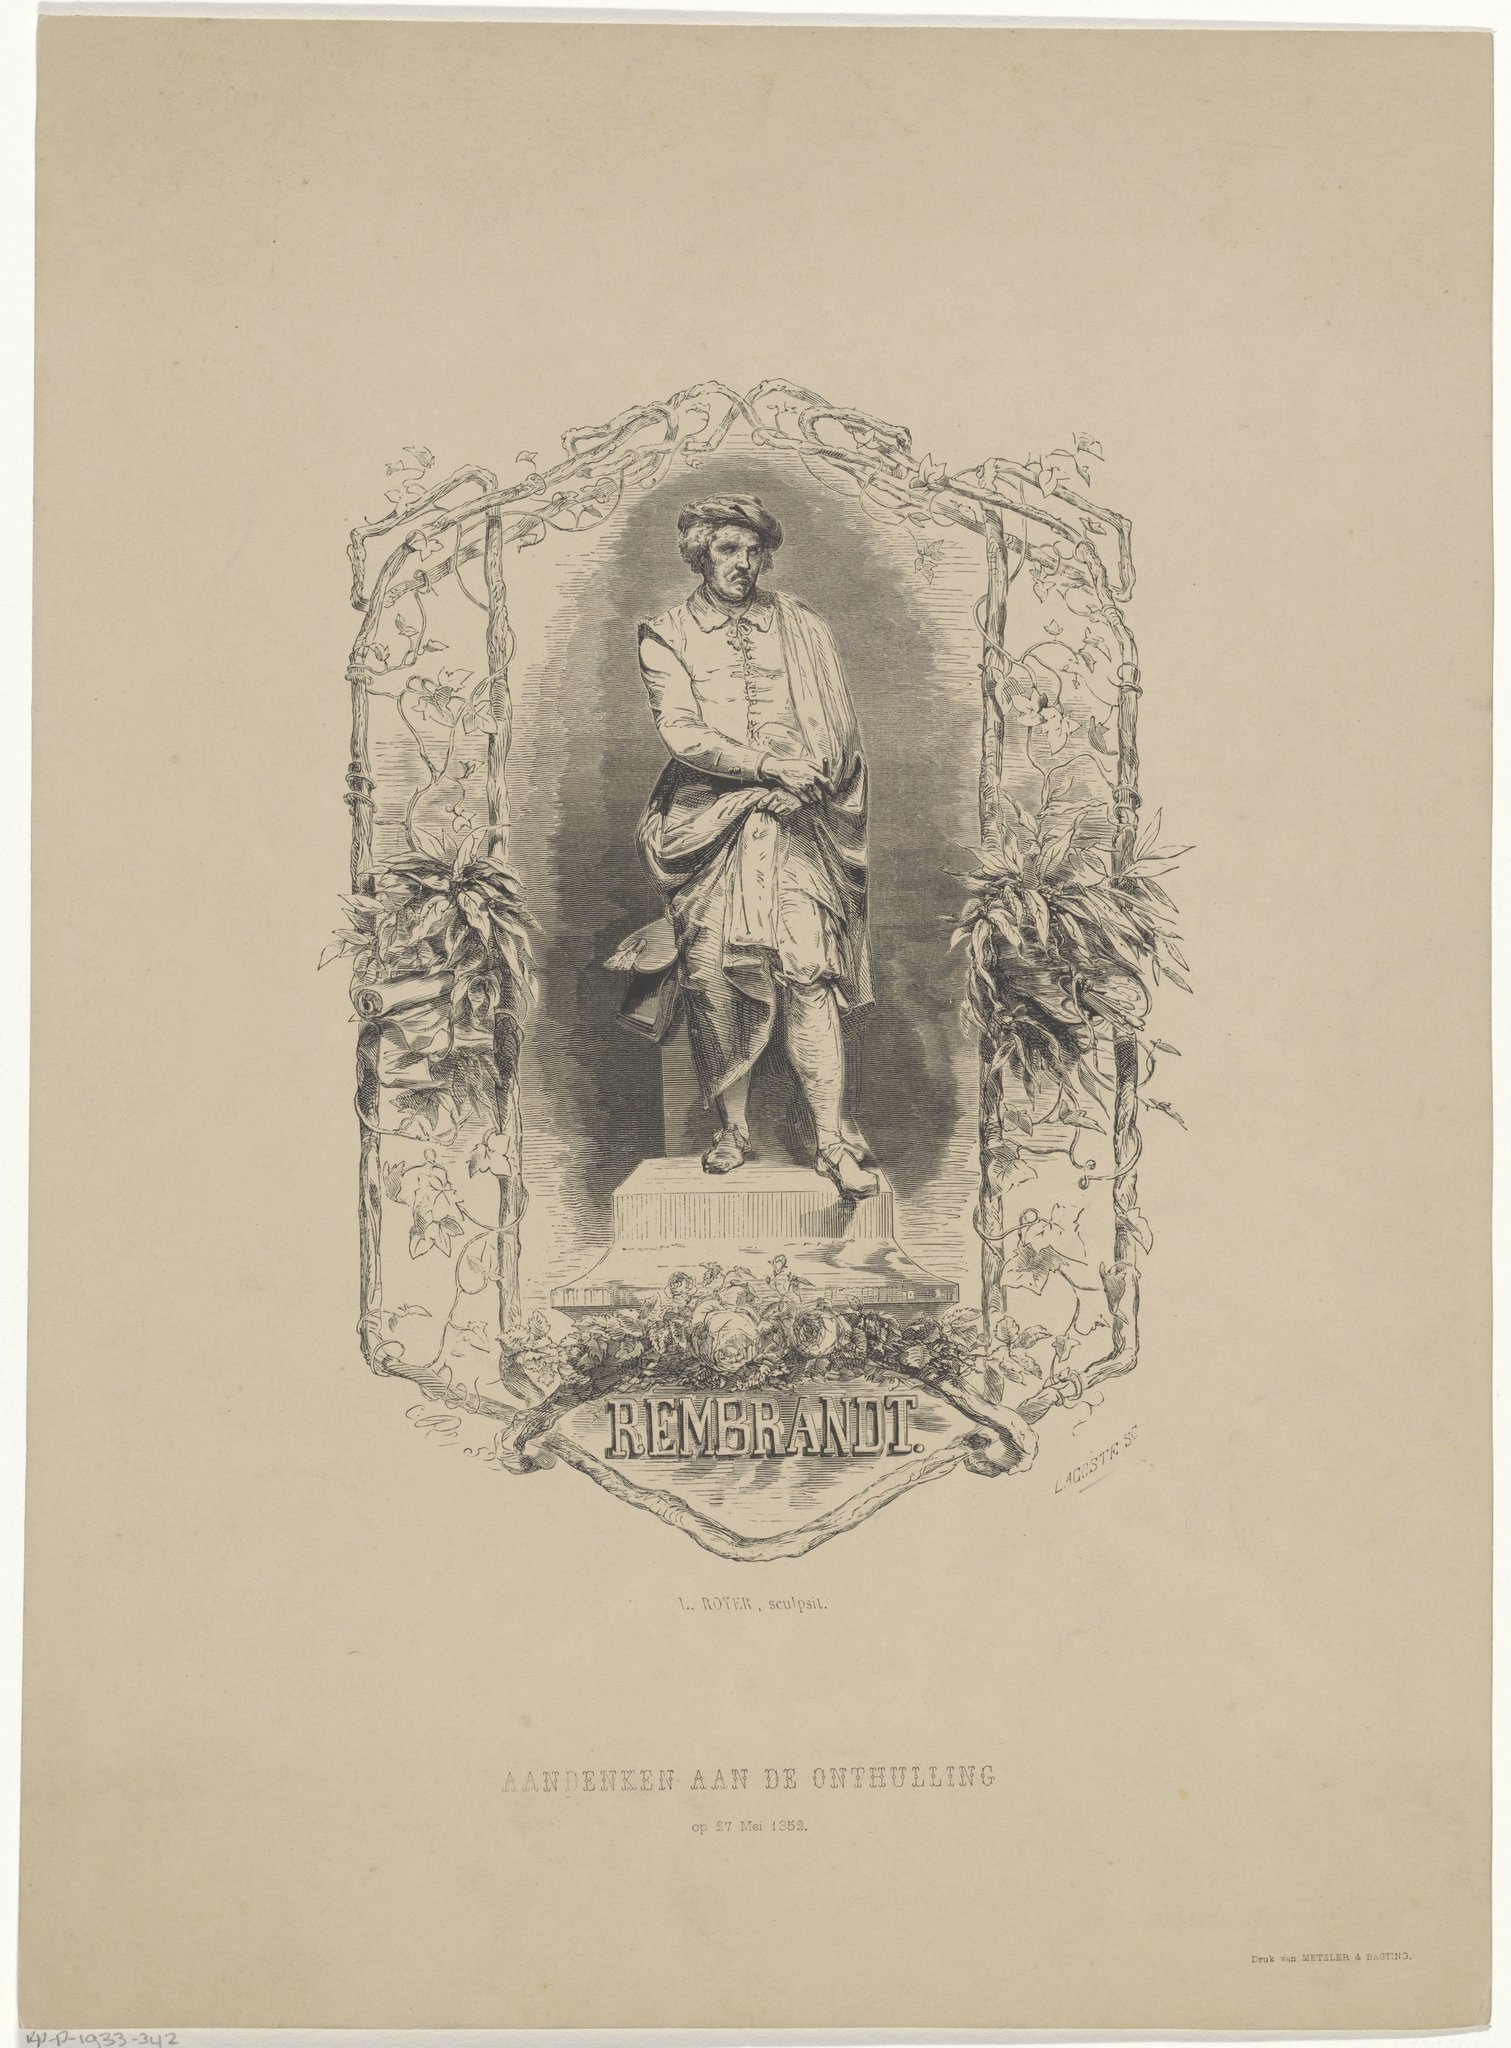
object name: print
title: Standbeeld van Rembrandt Harmensz. van Rijn op het Rembrandtplein te Amsterdam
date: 1852-1854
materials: paper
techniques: engraving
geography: netherlands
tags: leiden, amsterdam, painter, print maker, draughtsman, rembrandt van rijn, monument, statue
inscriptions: collector's mark: Lugt 10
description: Vervaardigd ter gelegenheid van de onthulling op 27 mei 1852.